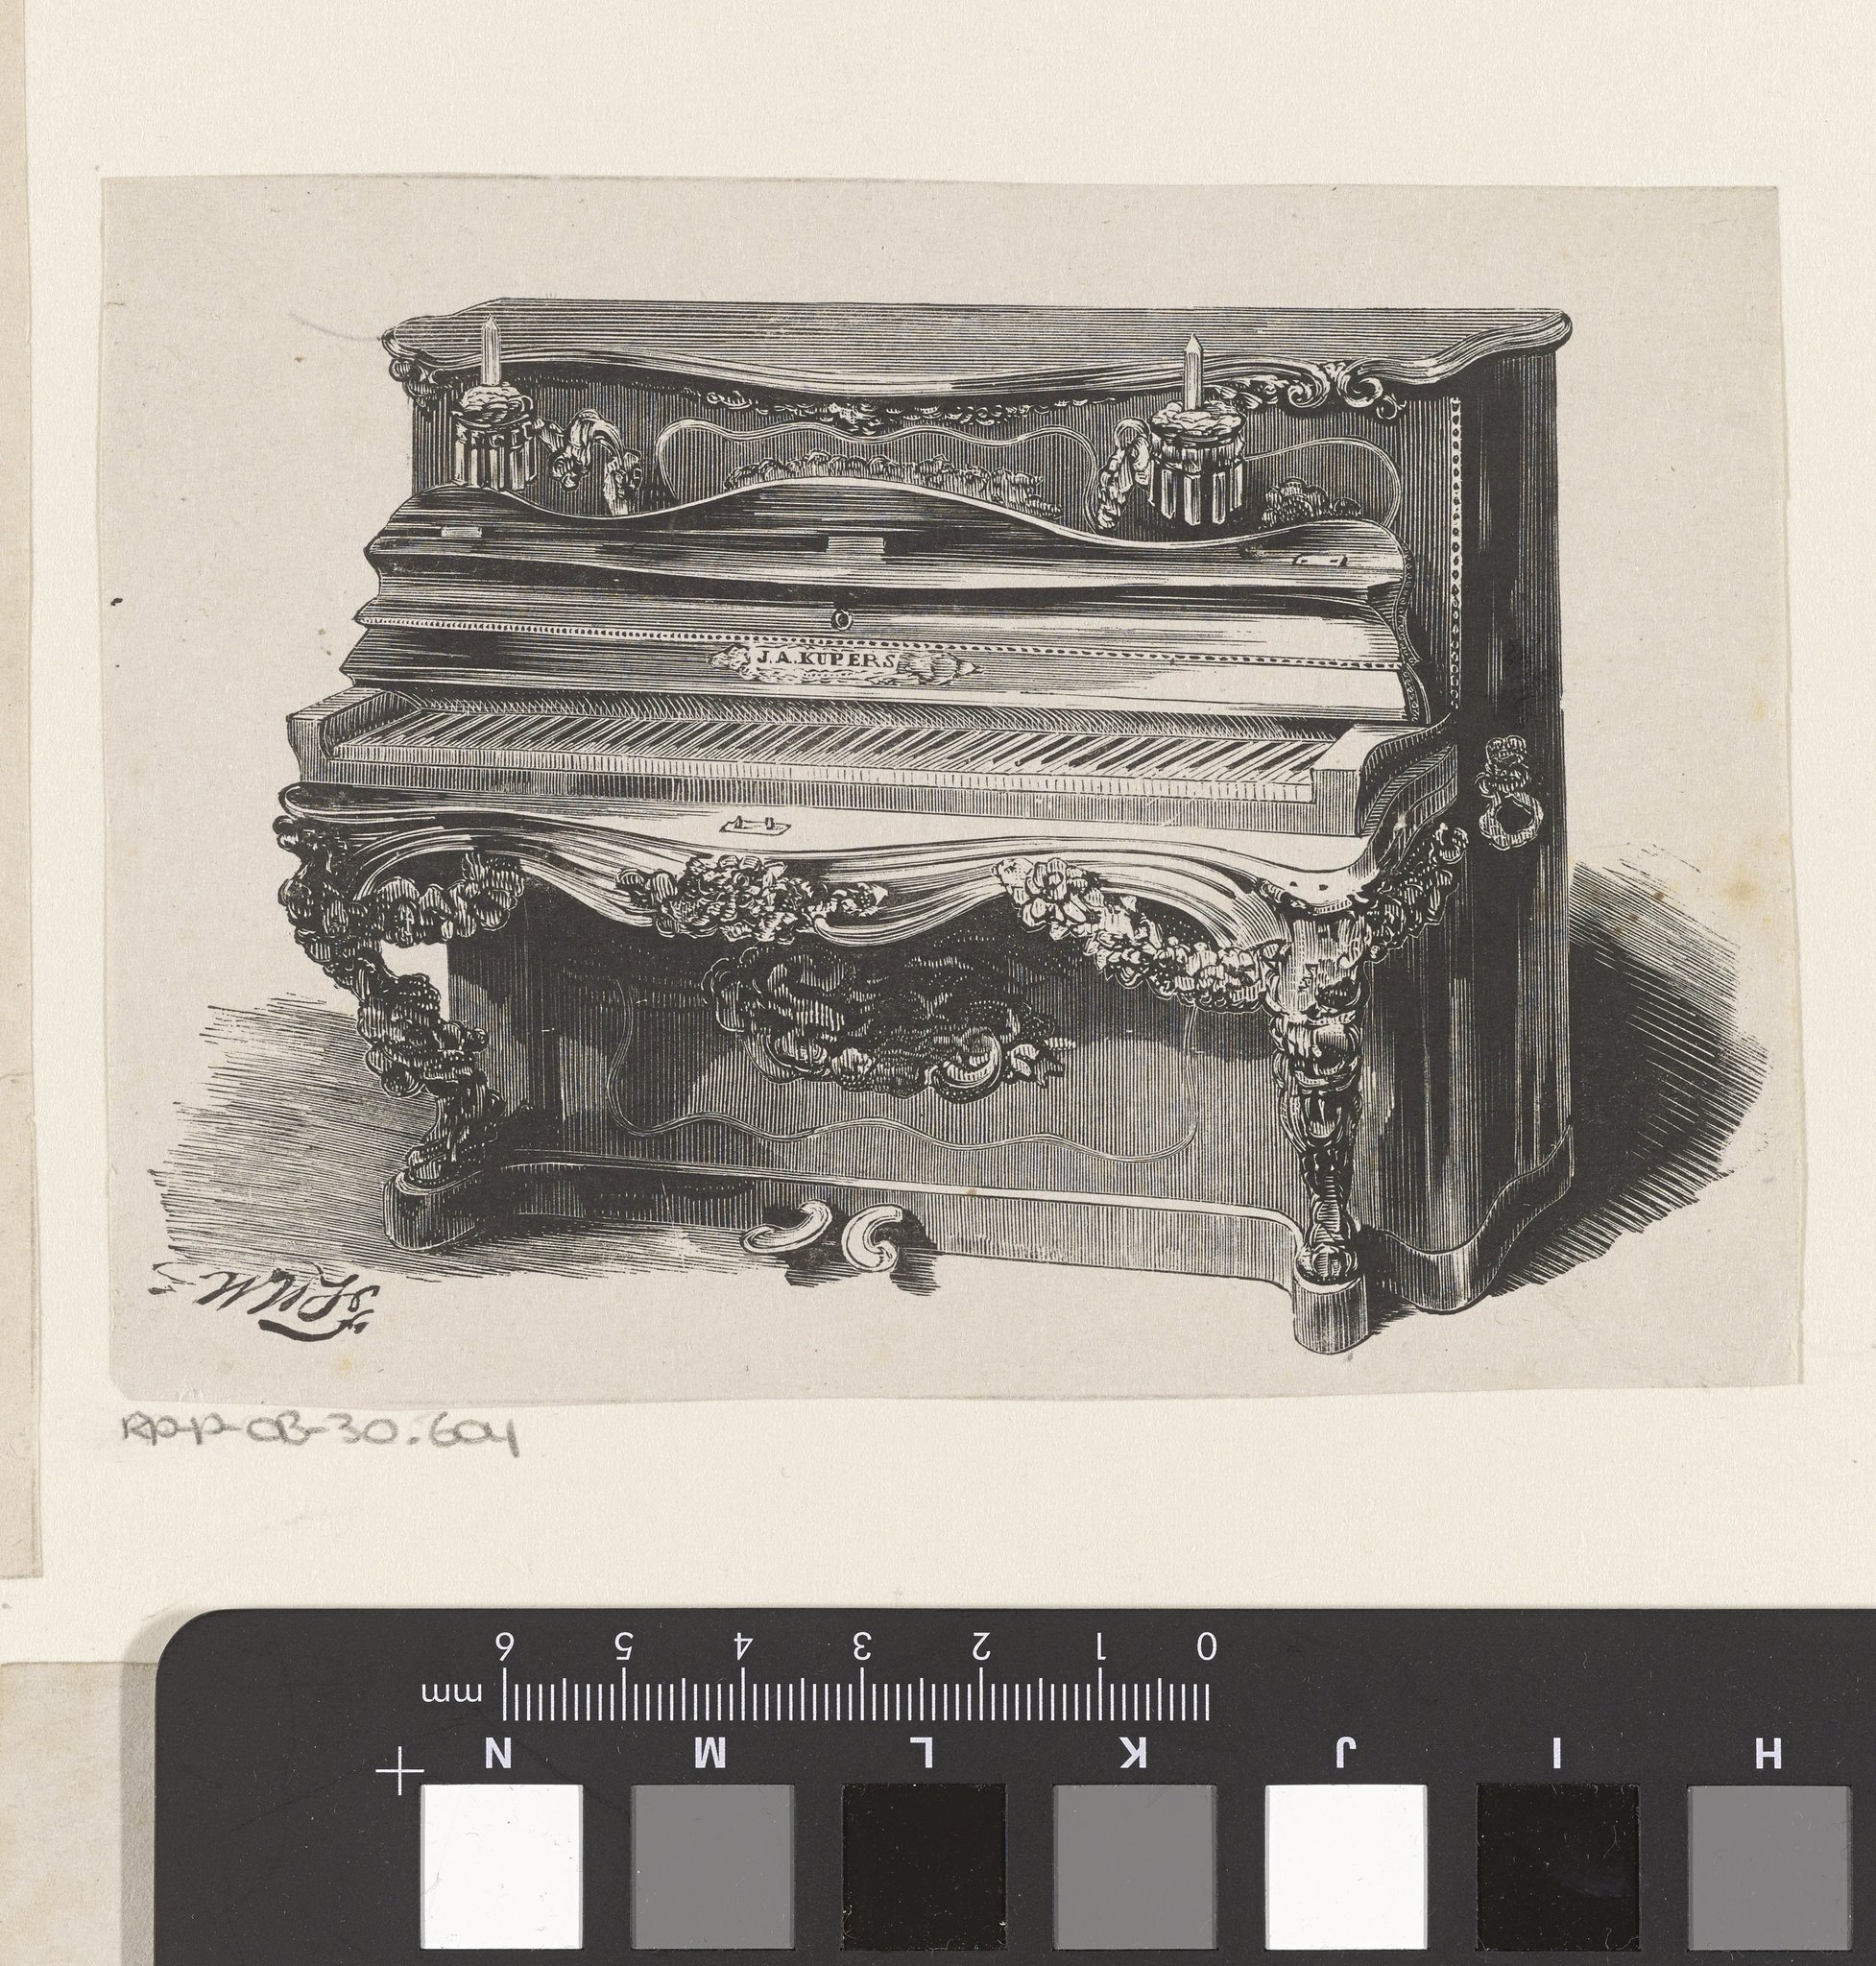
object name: print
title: Piano van J.A. Kupers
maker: isaac weissenbruch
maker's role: print maker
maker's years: 1826-1912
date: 1836-1912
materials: paper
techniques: engraving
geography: netherlands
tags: grand piano